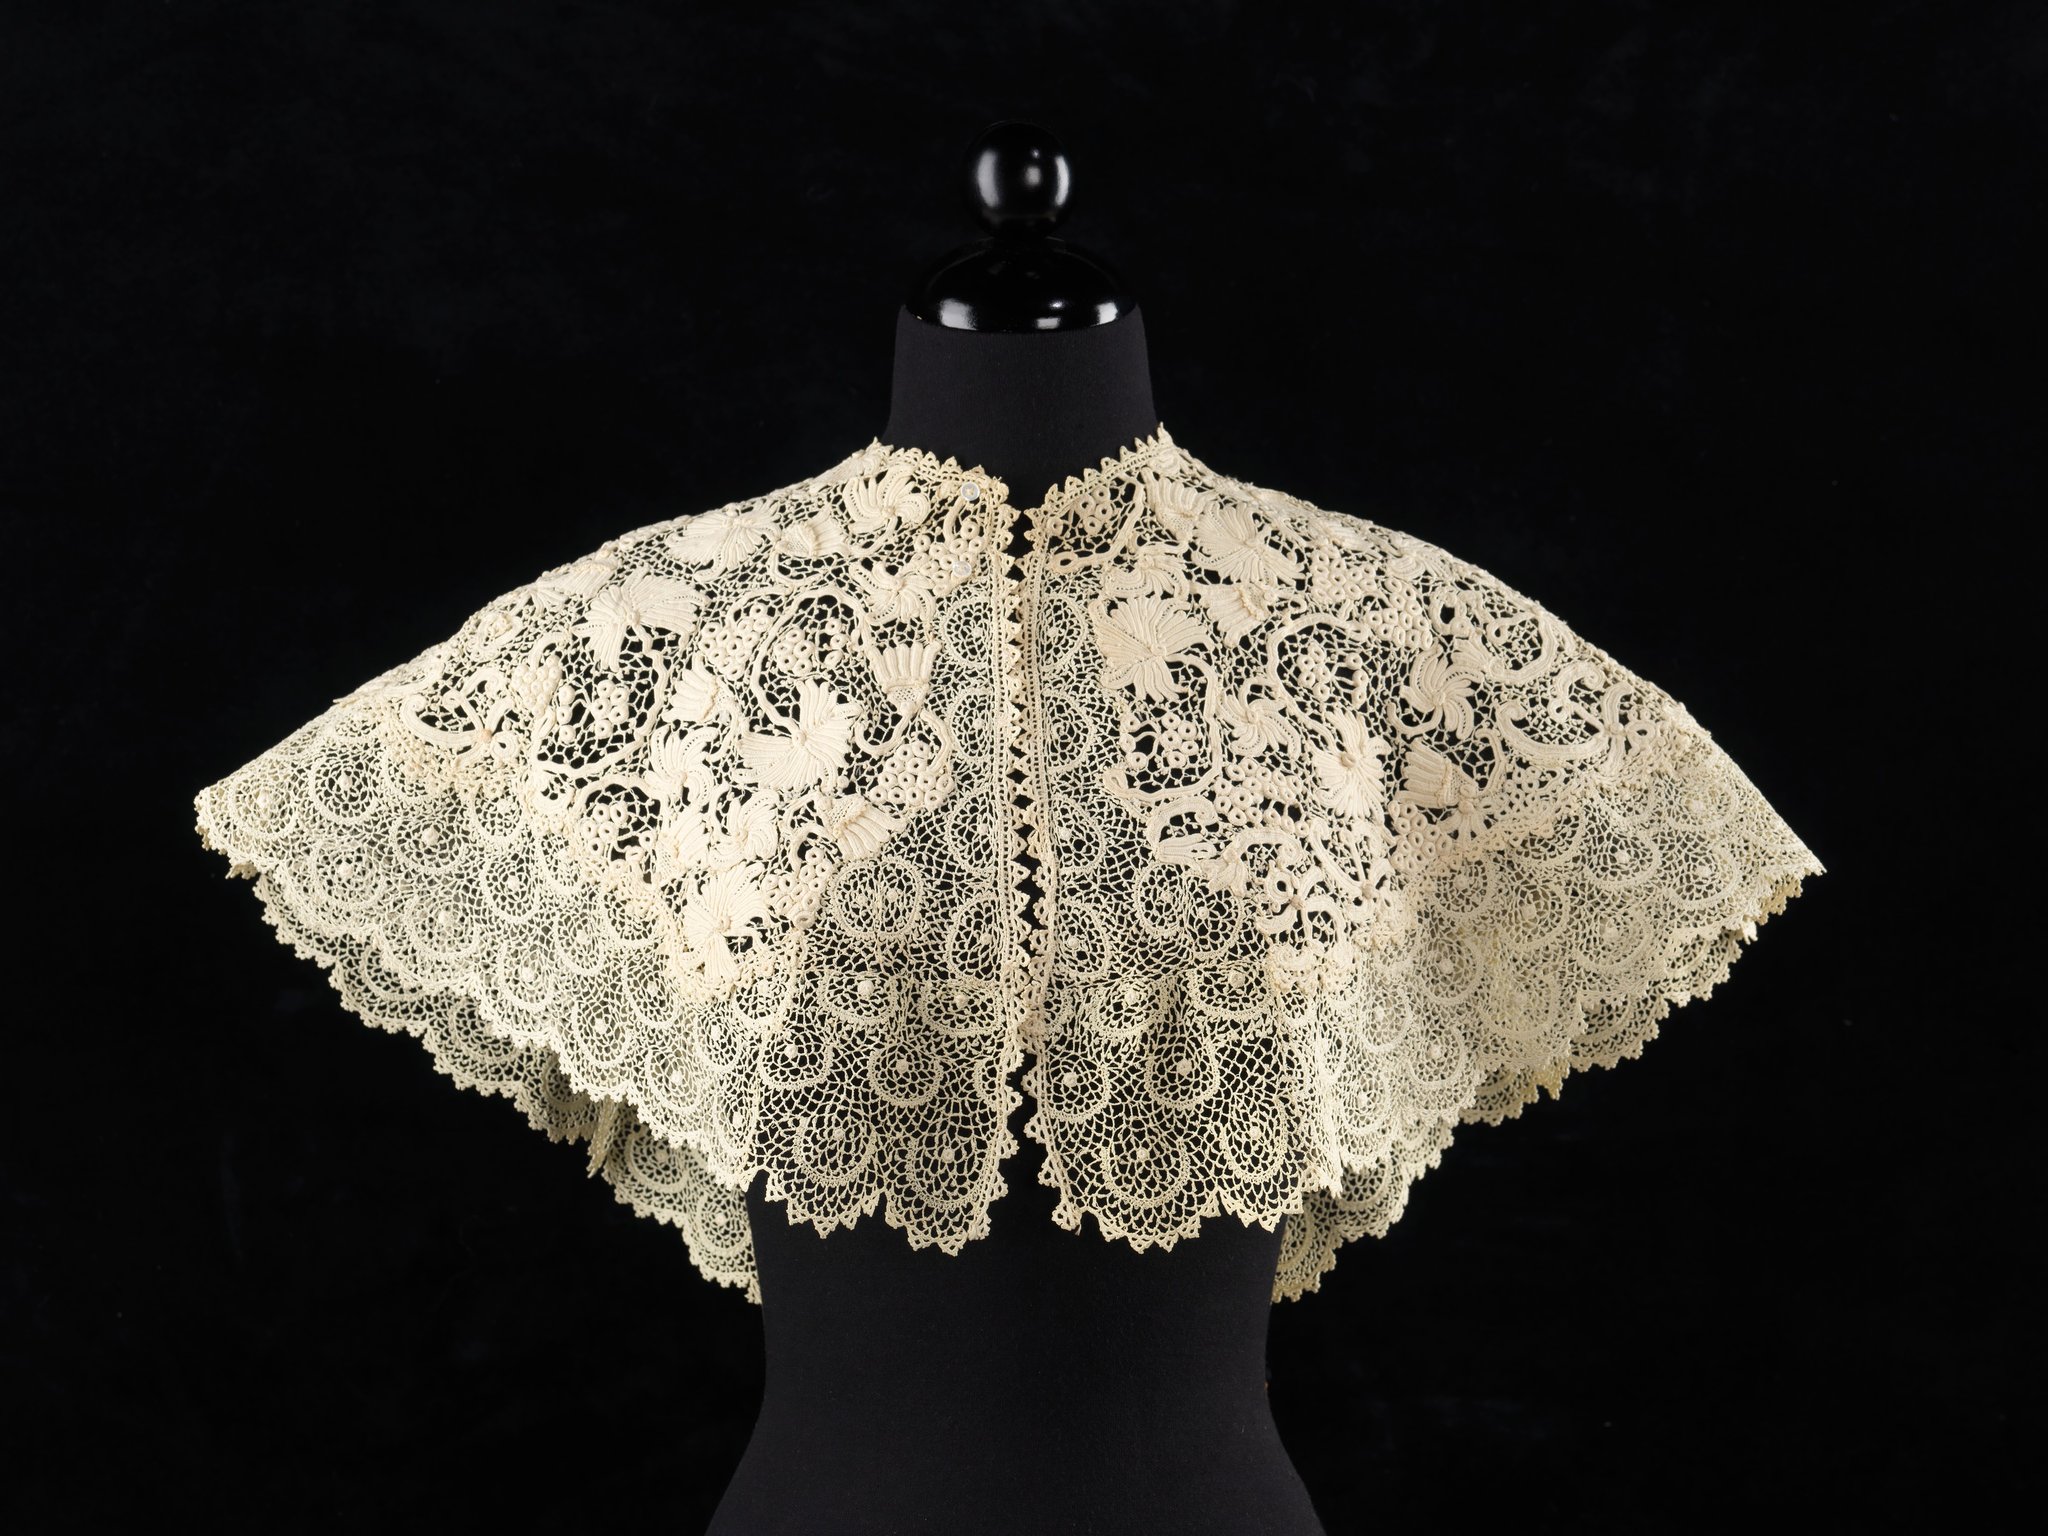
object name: collar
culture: irish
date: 1890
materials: cotton